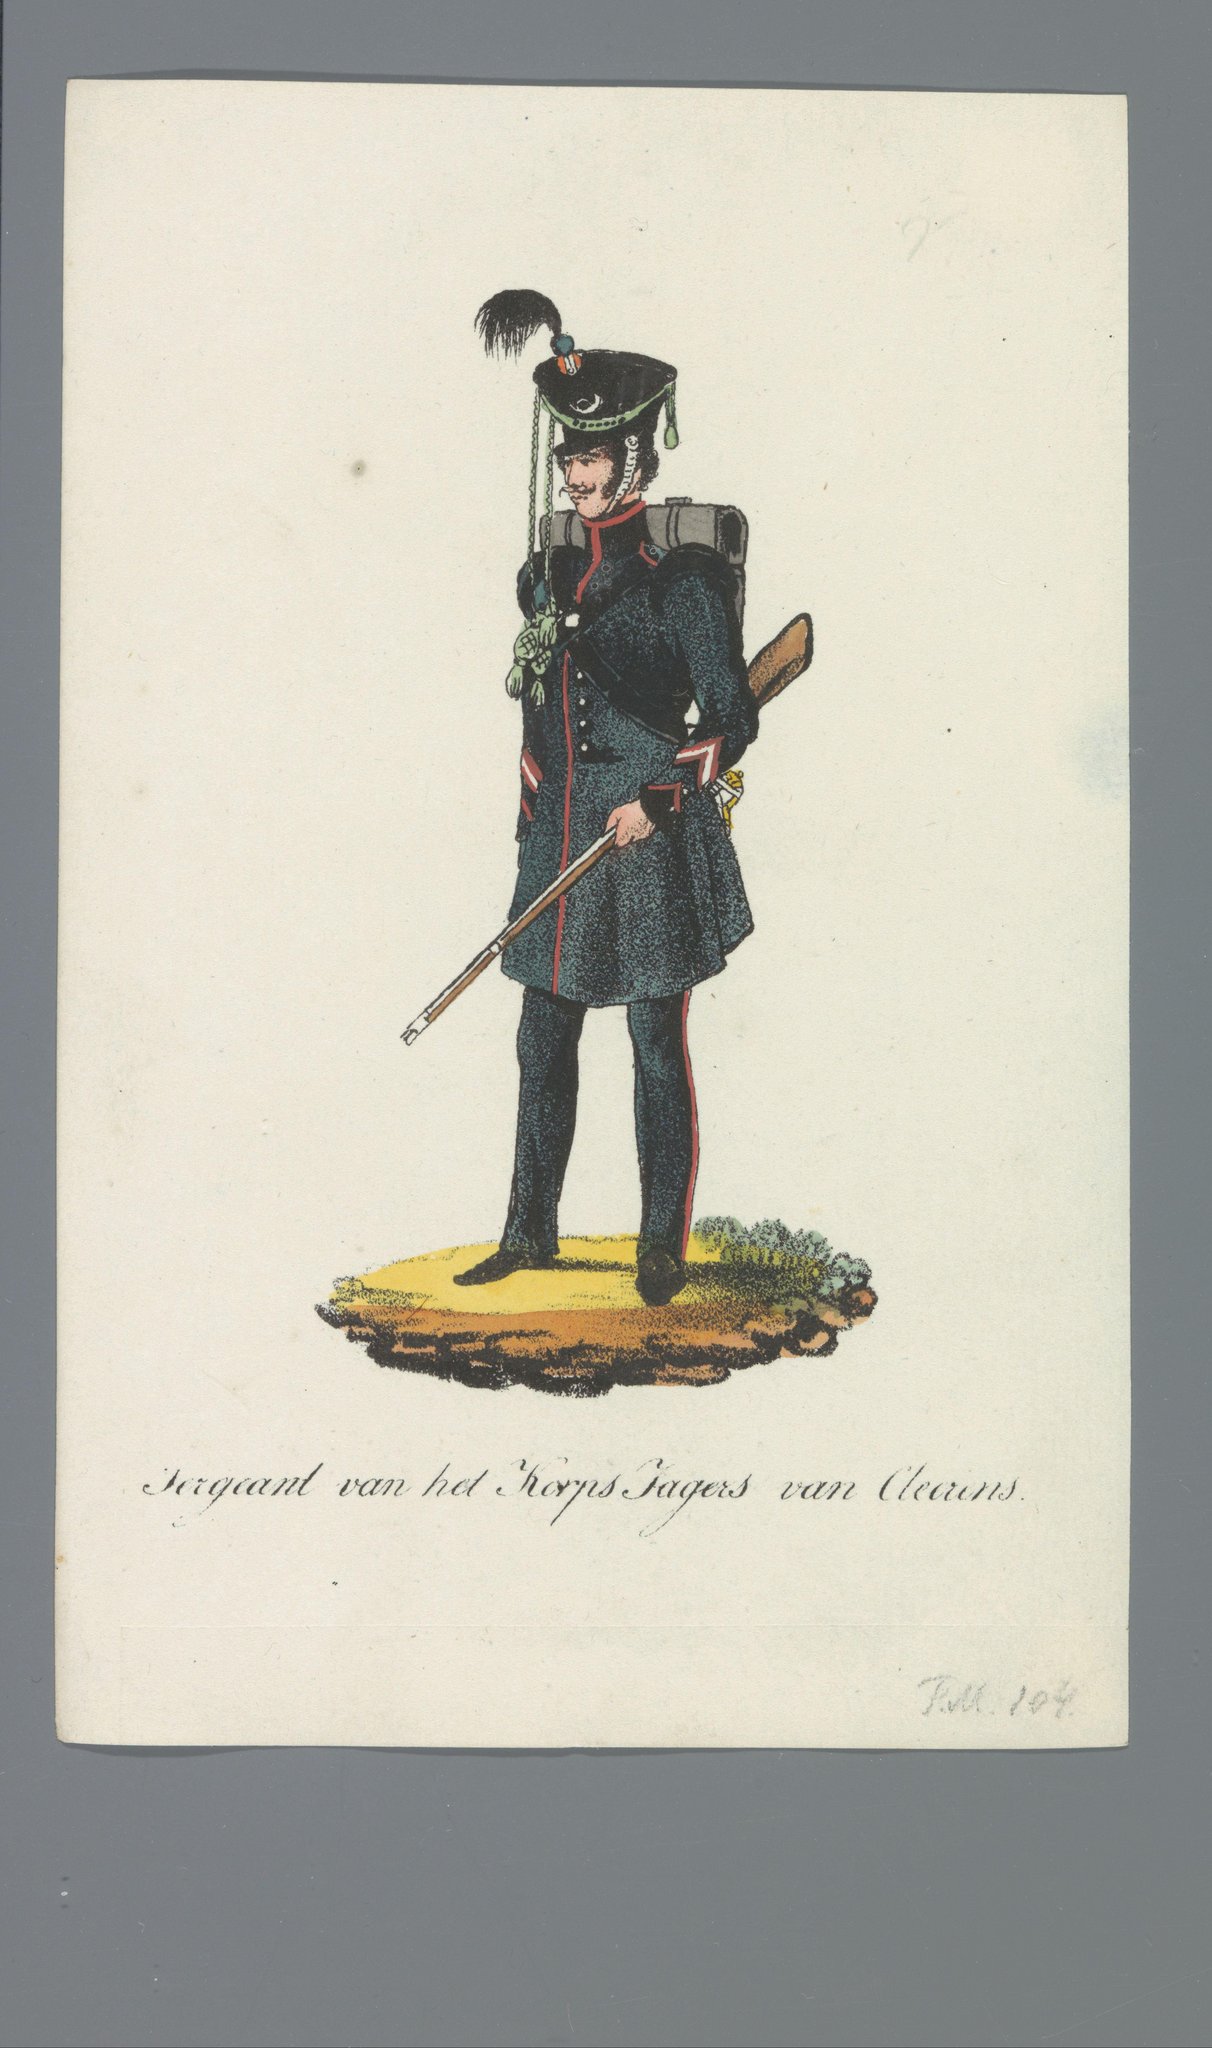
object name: costume print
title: Sergeaant van het Korps Jagers van Cleerens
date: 1835-1850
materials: paper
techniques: hand coloring, lithograph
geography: netherlands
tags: (military) uniforms, clothes, costume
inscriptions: collector's mark: Lugt 2228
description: Een sergeant van het Korps Jagers van Cleerens, te voet. Onderdeel van een serie van 157 losse bladen met Nederlandse militaire uniformen in de jaren 1830-1832.